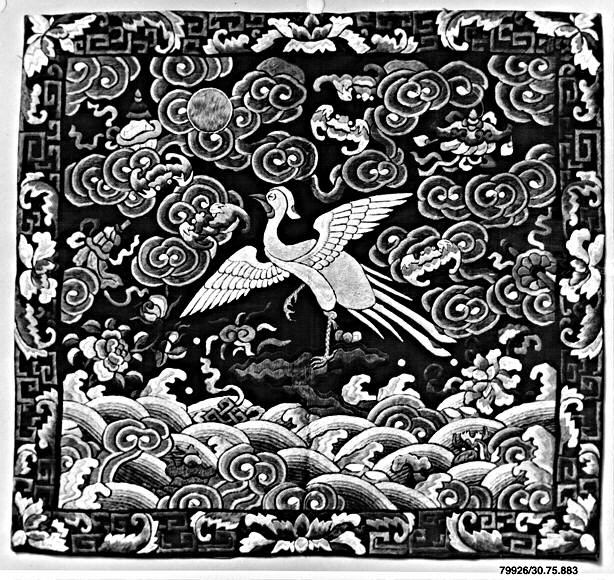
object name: rank badge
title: Rank Badge with Paradise Fly-Catcher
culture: chinese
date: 1801-1900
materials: silk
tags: bats,birds